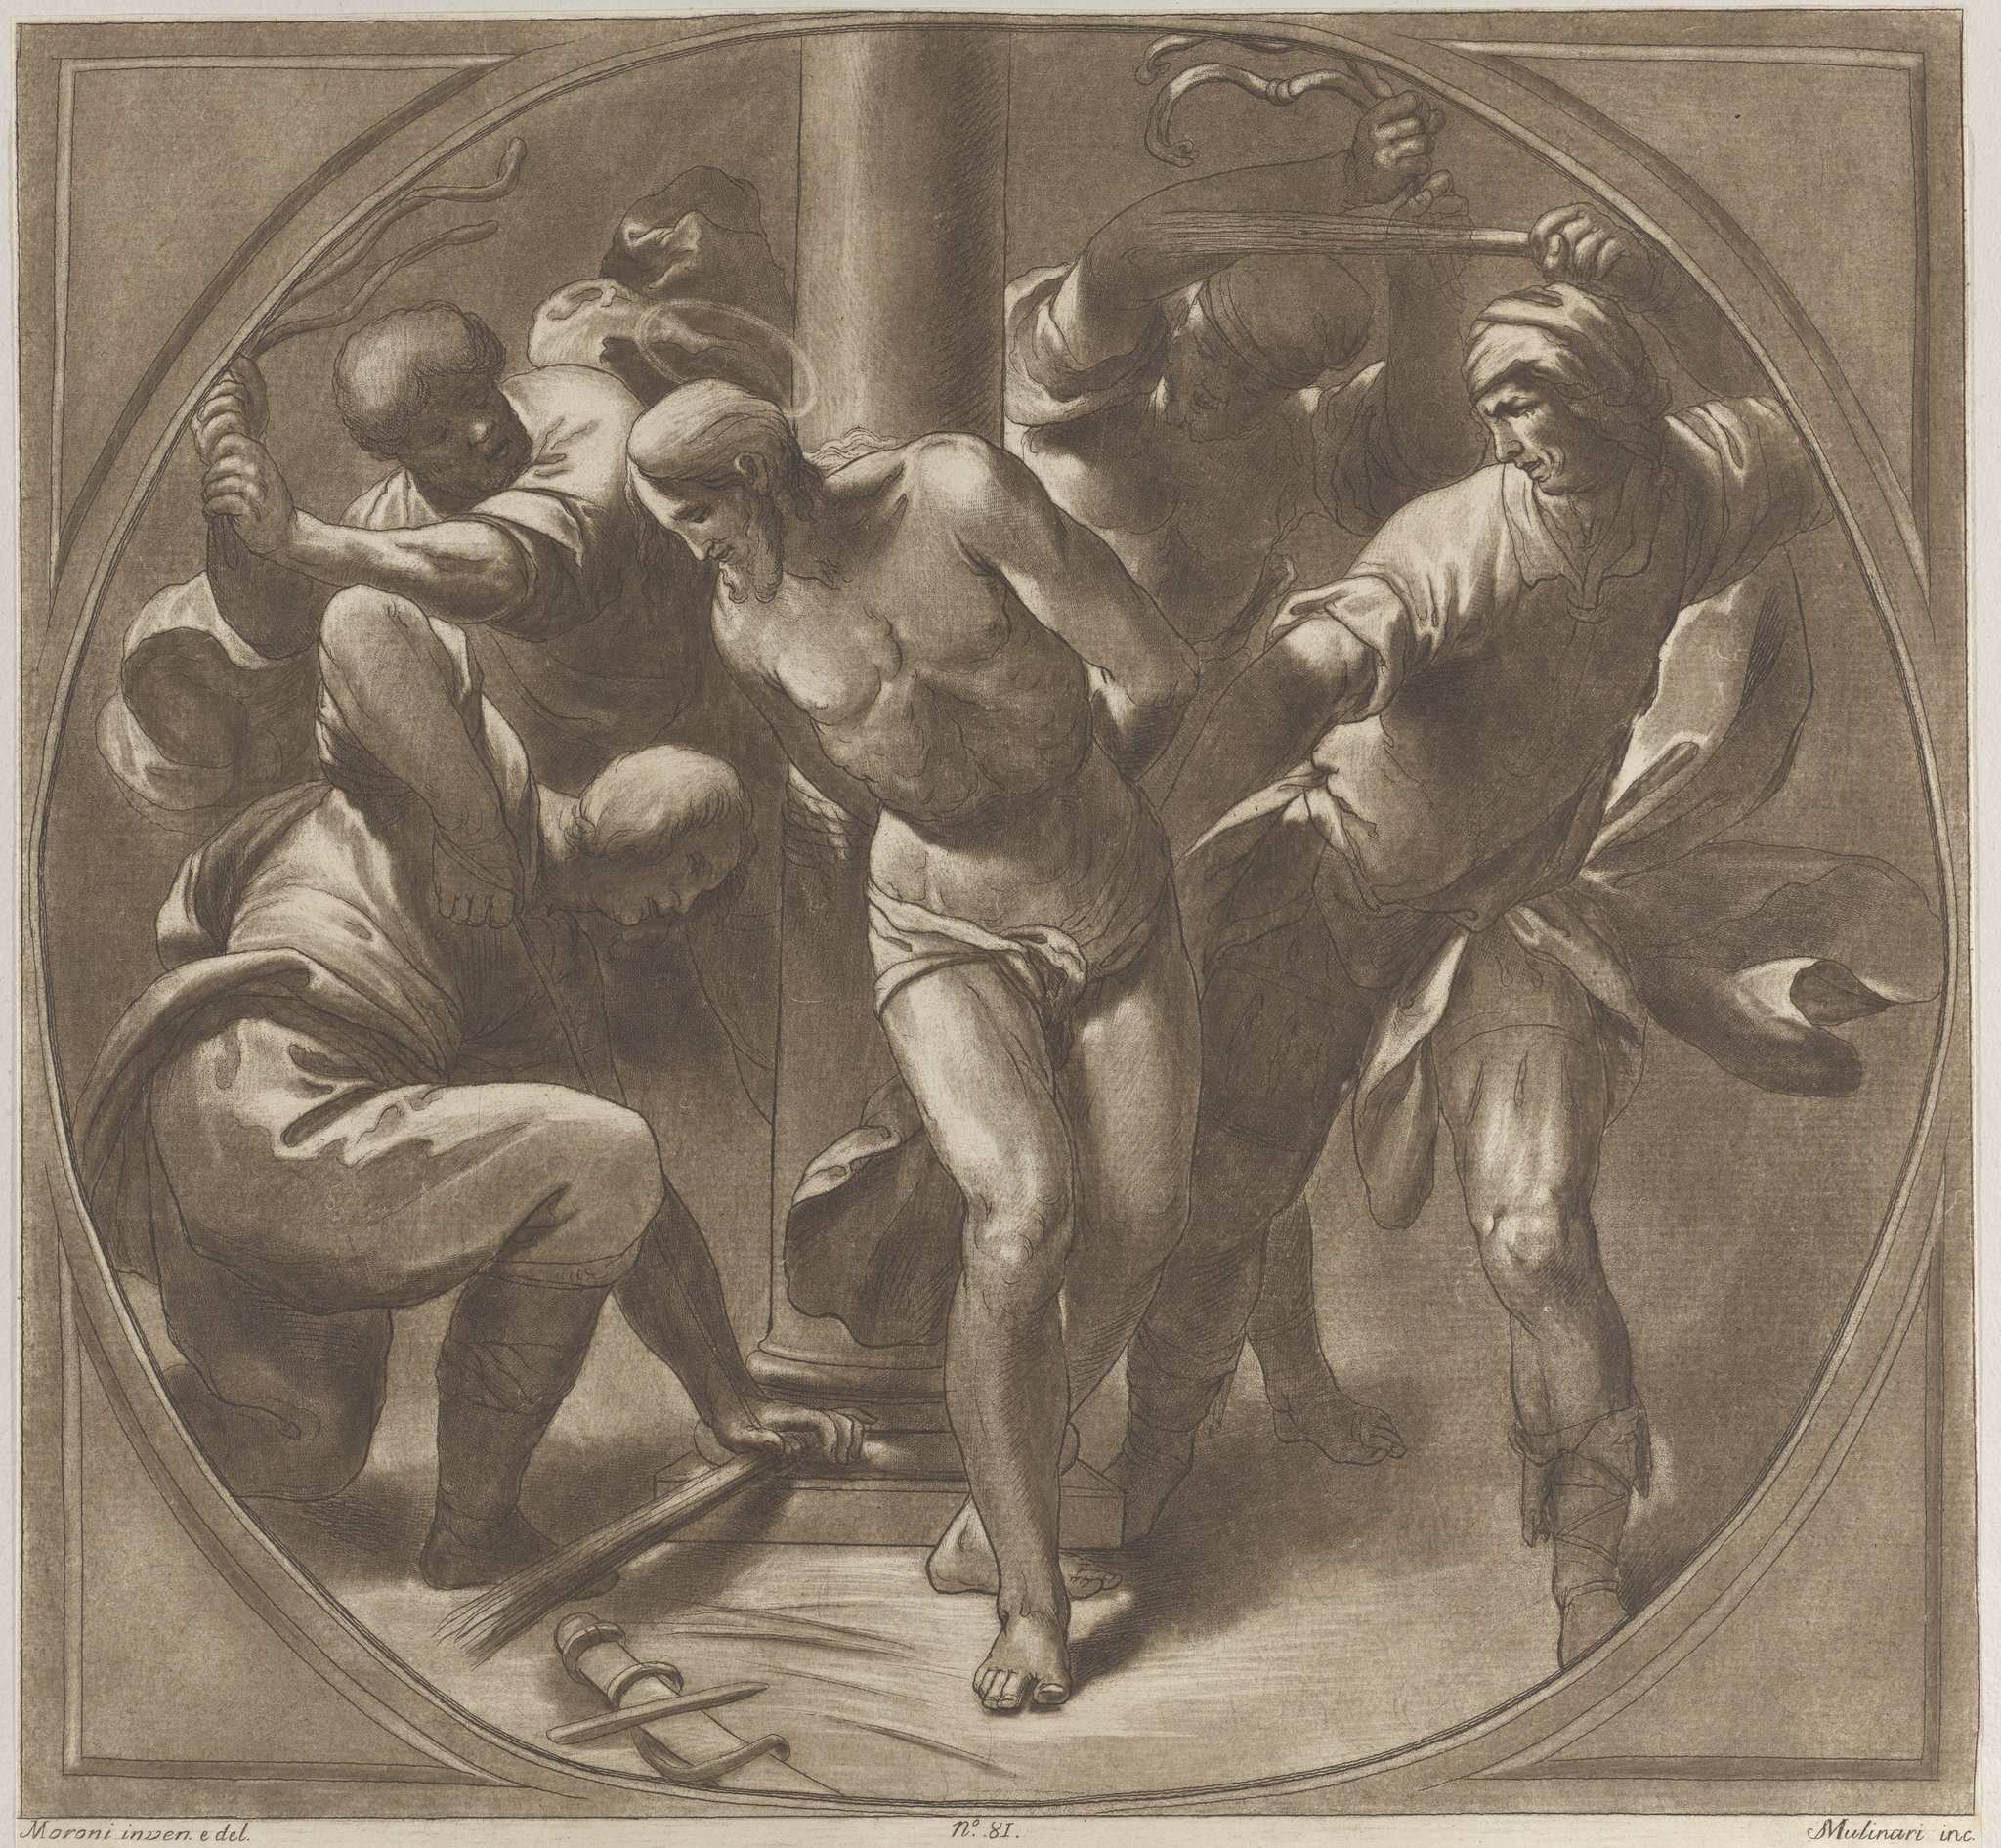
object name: print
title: Flagellation of Christ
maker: stefano mulinari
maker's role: artist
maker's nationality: italian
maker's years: 1736-1795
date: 1760-1790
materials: ink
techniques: aquatint, etching